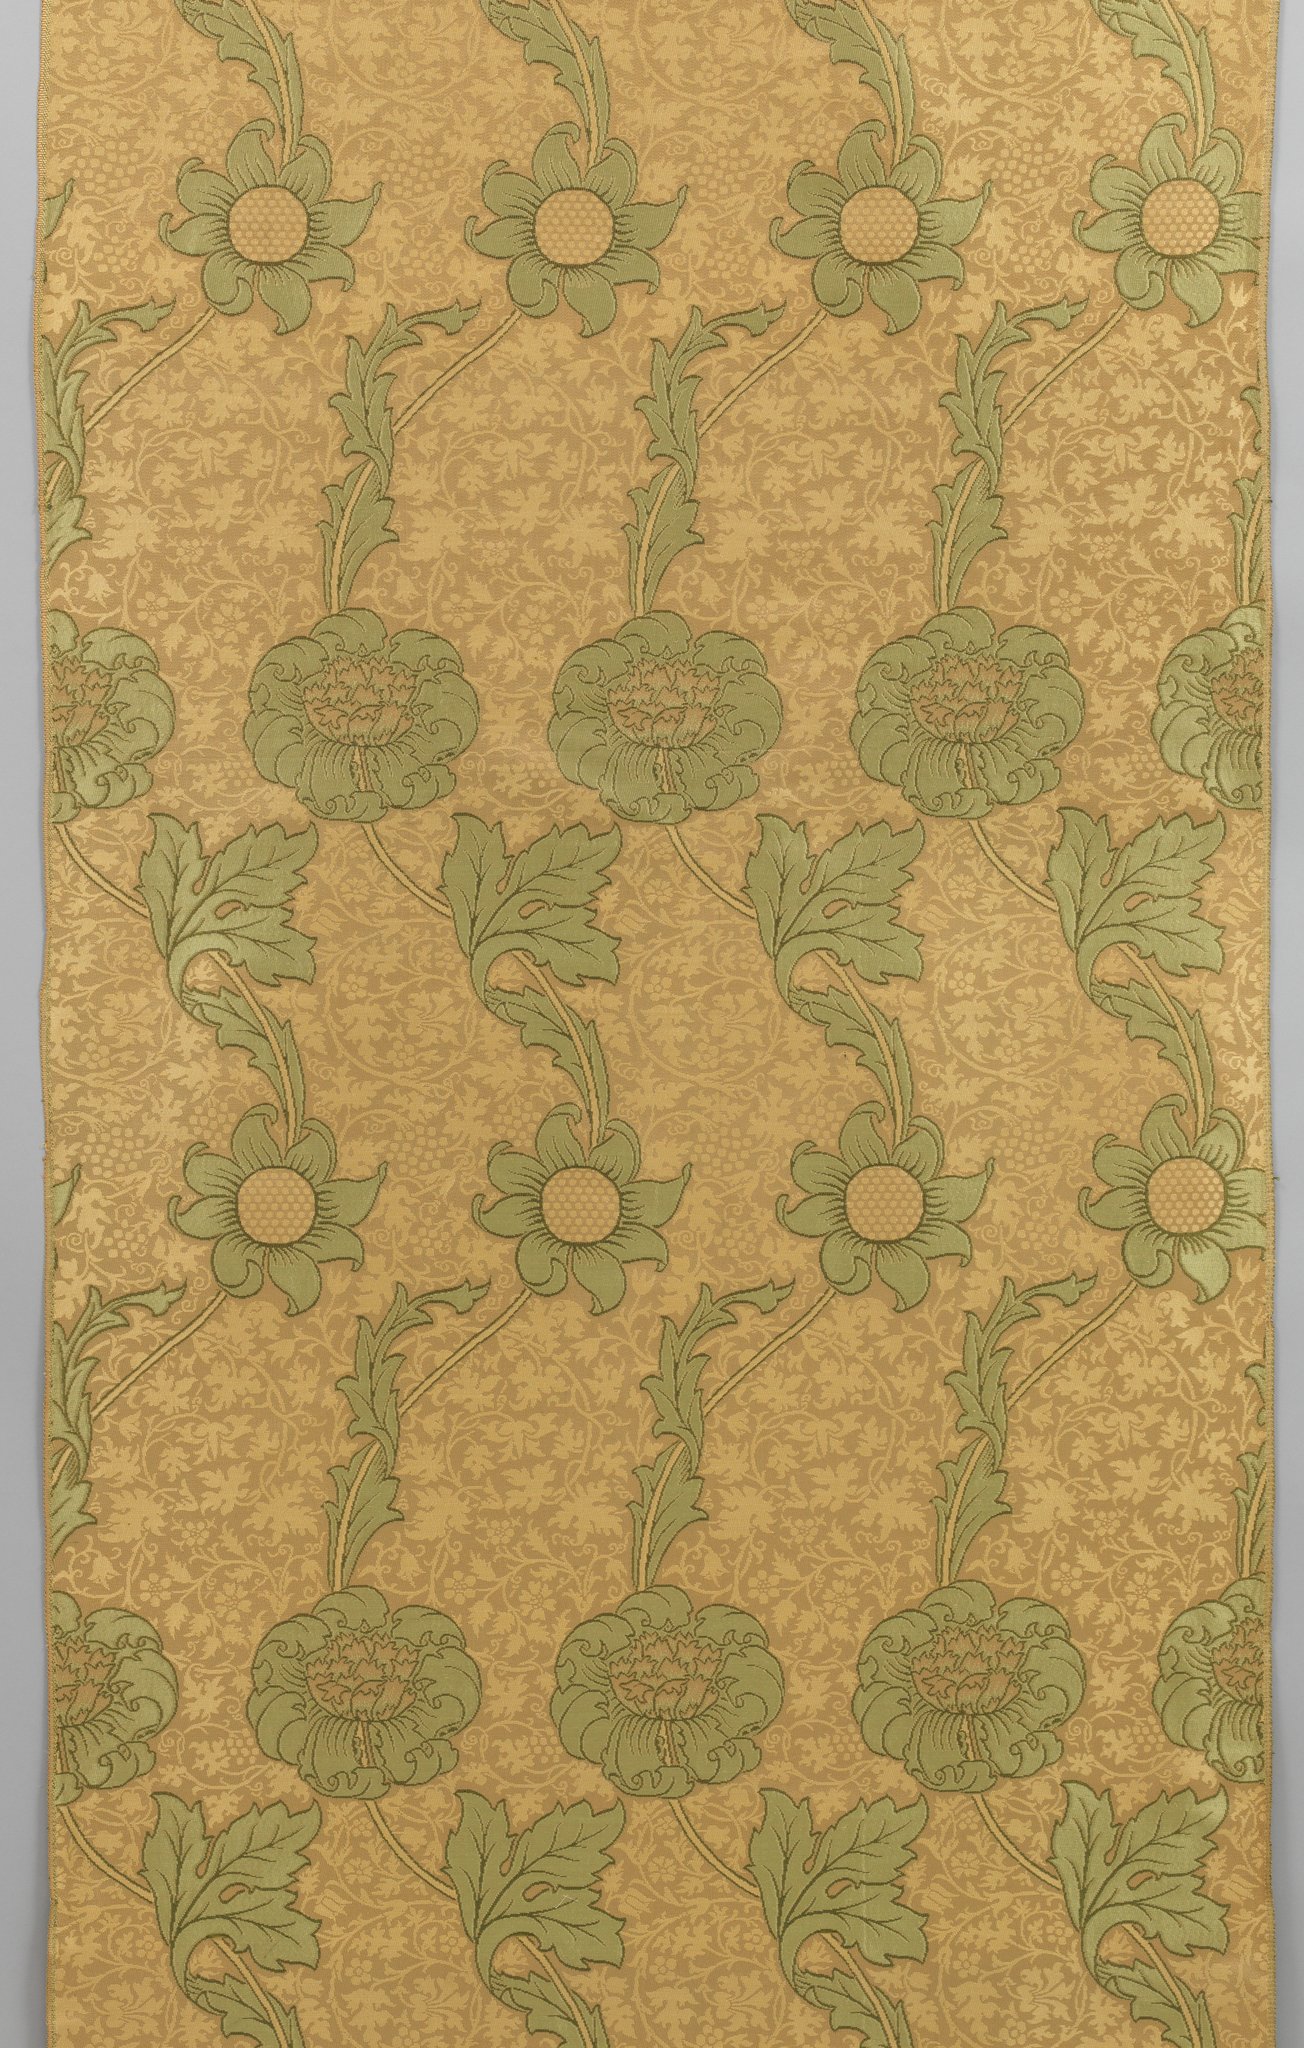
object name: length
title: Kennet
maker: william morris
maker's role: designer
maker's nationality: british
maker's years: 1834-1896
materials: silk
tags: flowers